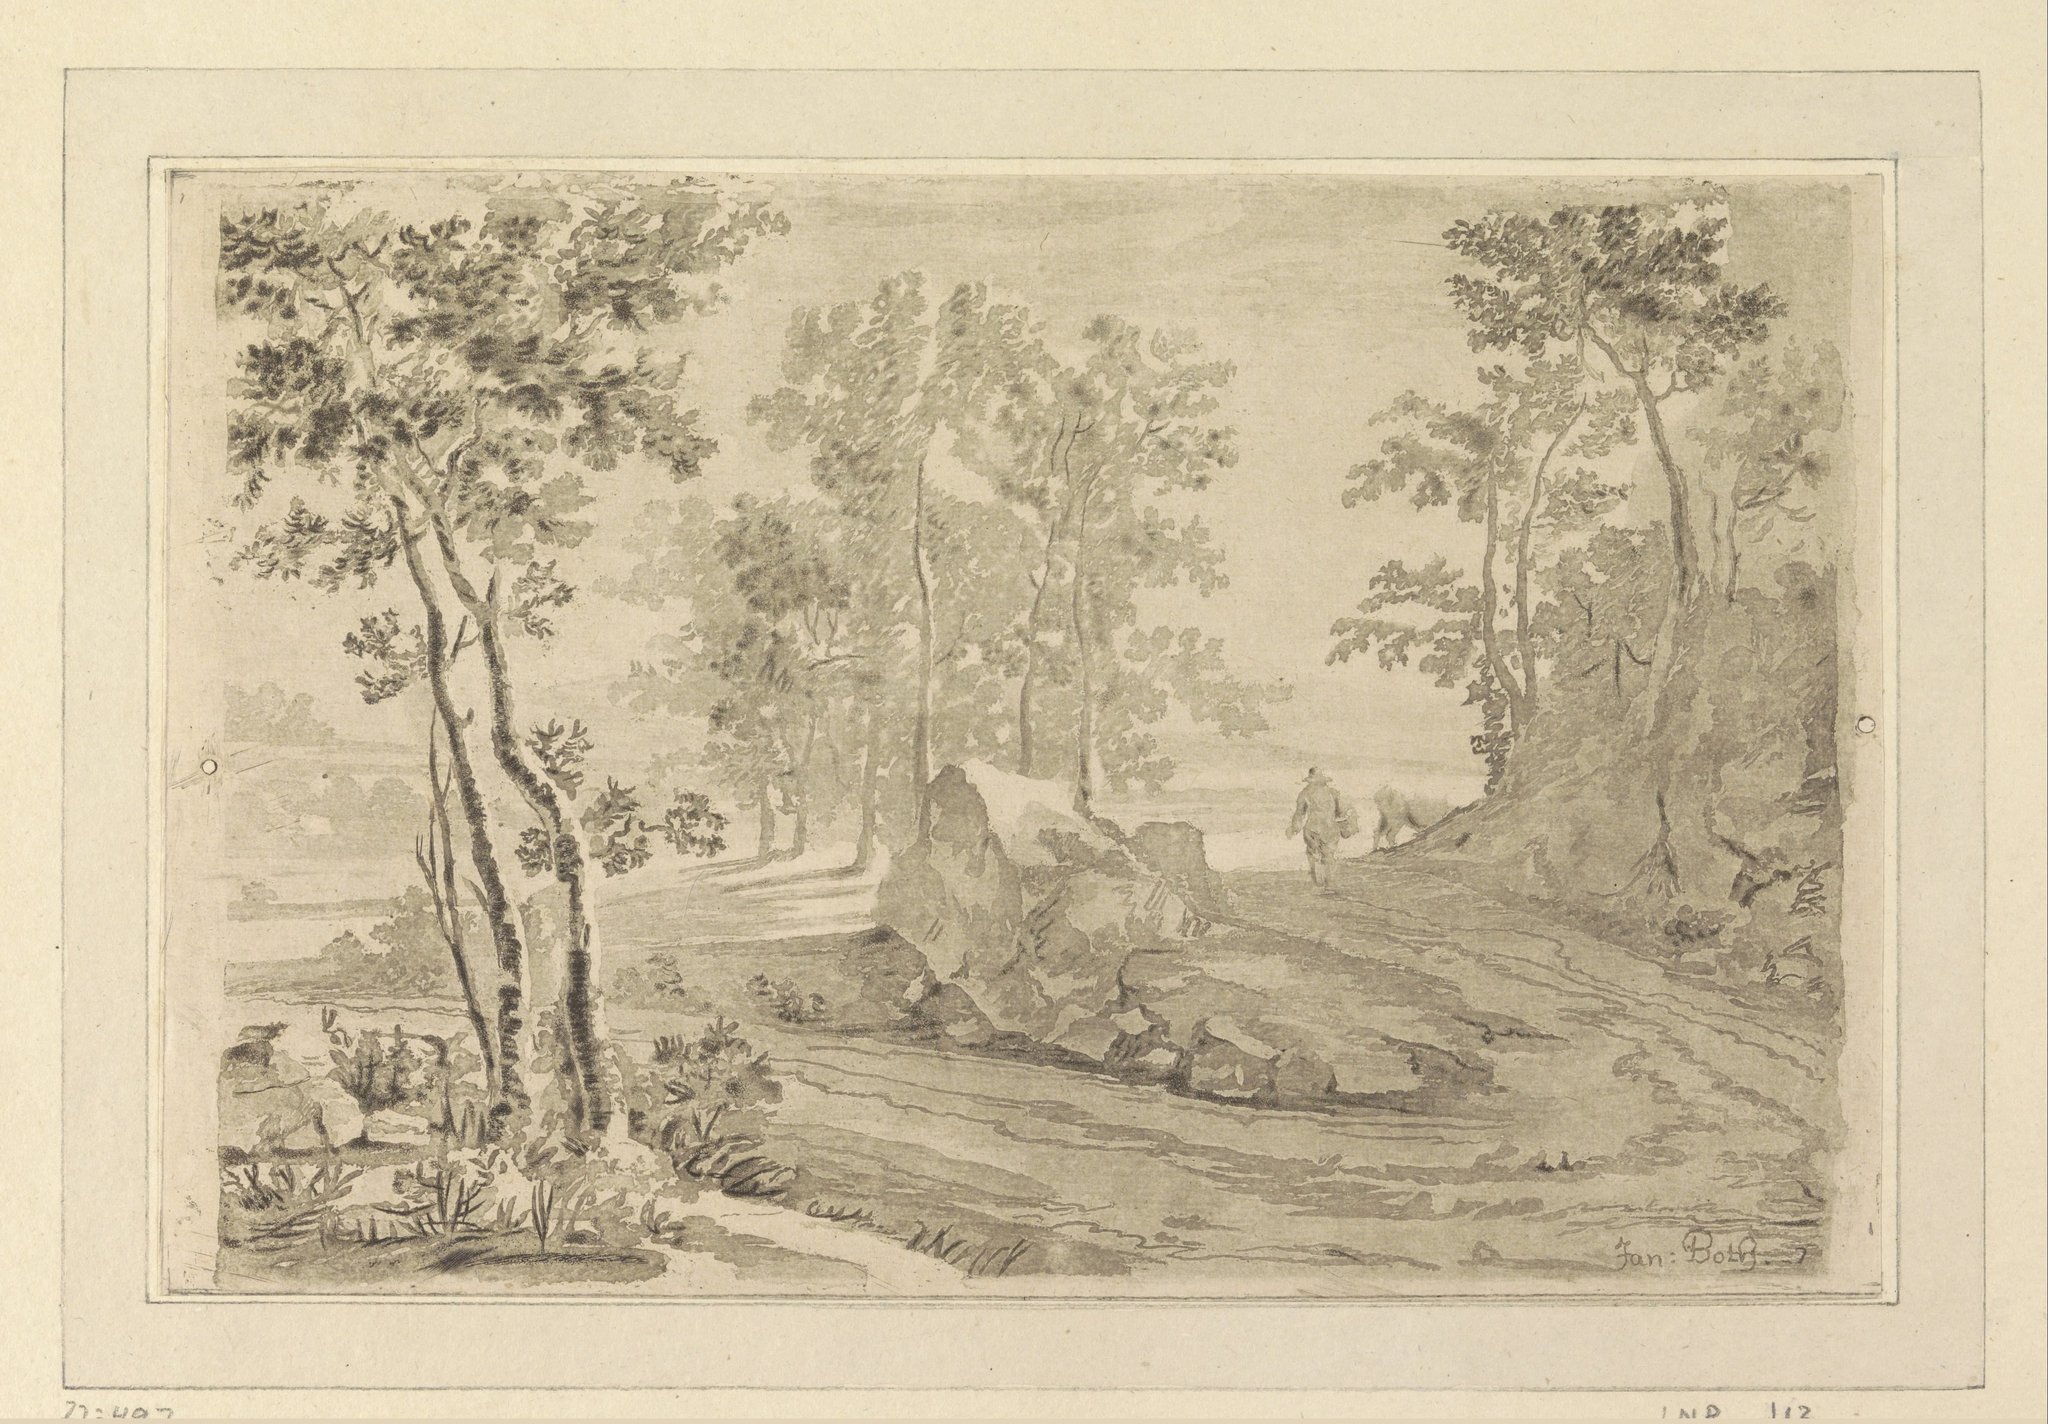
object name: print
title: Boomrijk landschap met veedrijver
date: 1795-1821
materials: paper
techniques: etching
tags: low hill country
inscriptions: collector's mark: Lugt 2228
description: De voltooide prent werd opgenomen in: Collection d'imitations de dessins d'après les principaux maîtres hollandais et flamands, Londen, C. Josi, 1821.